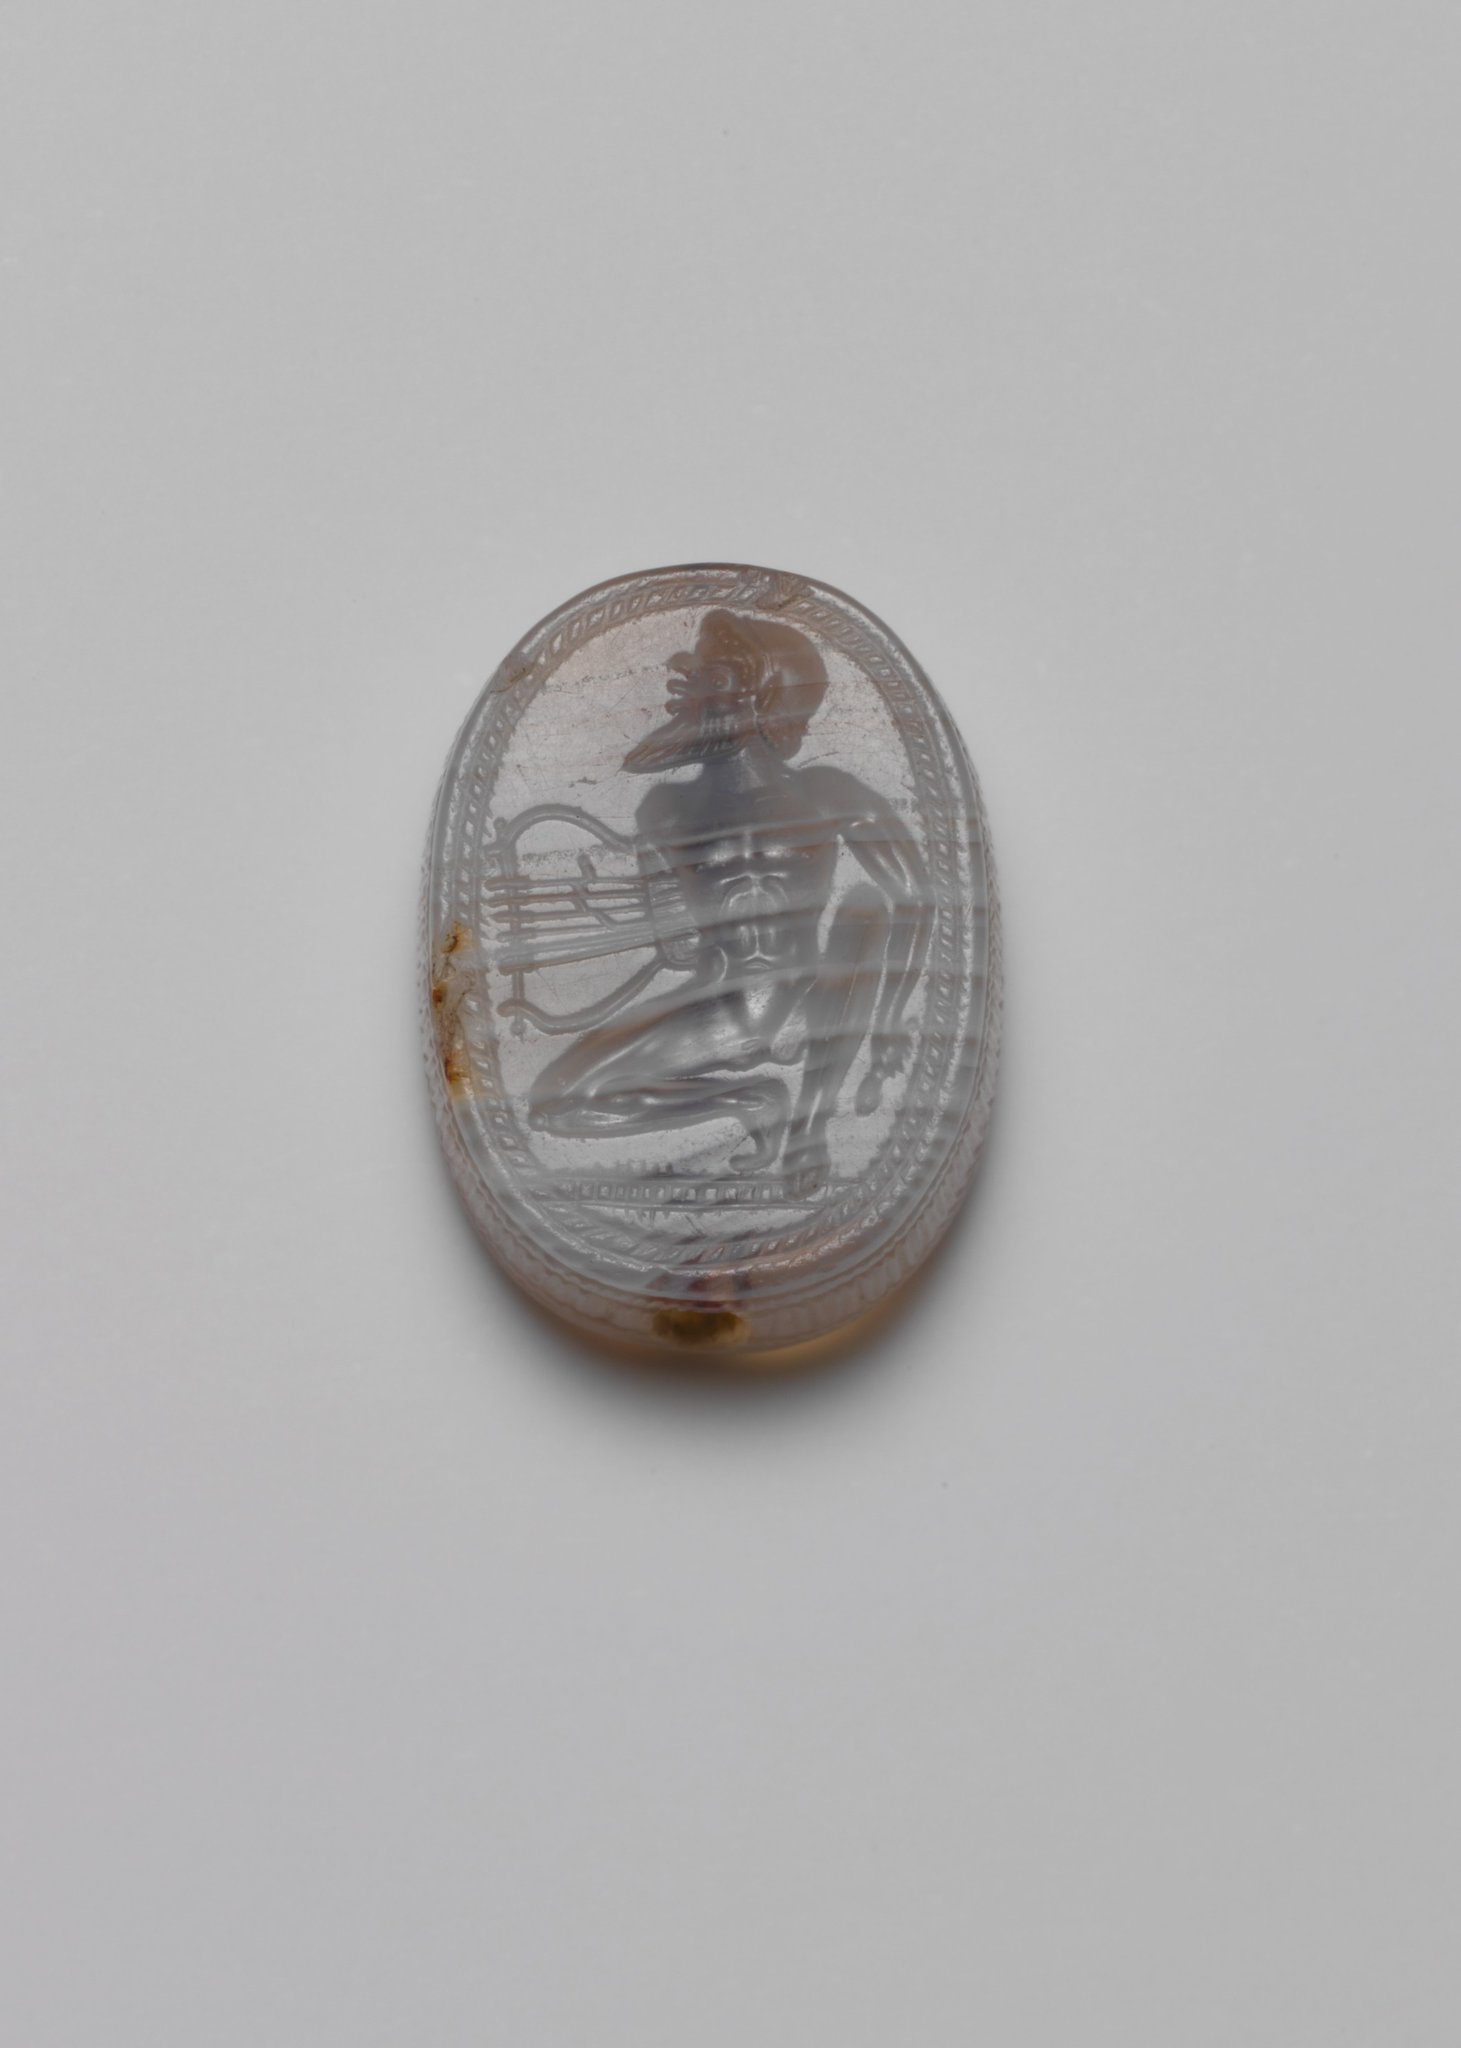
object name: scaraboid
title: Banded agate scaraboid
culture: etruscan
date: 480 BCE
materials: stone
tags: musical instruments,satyrs